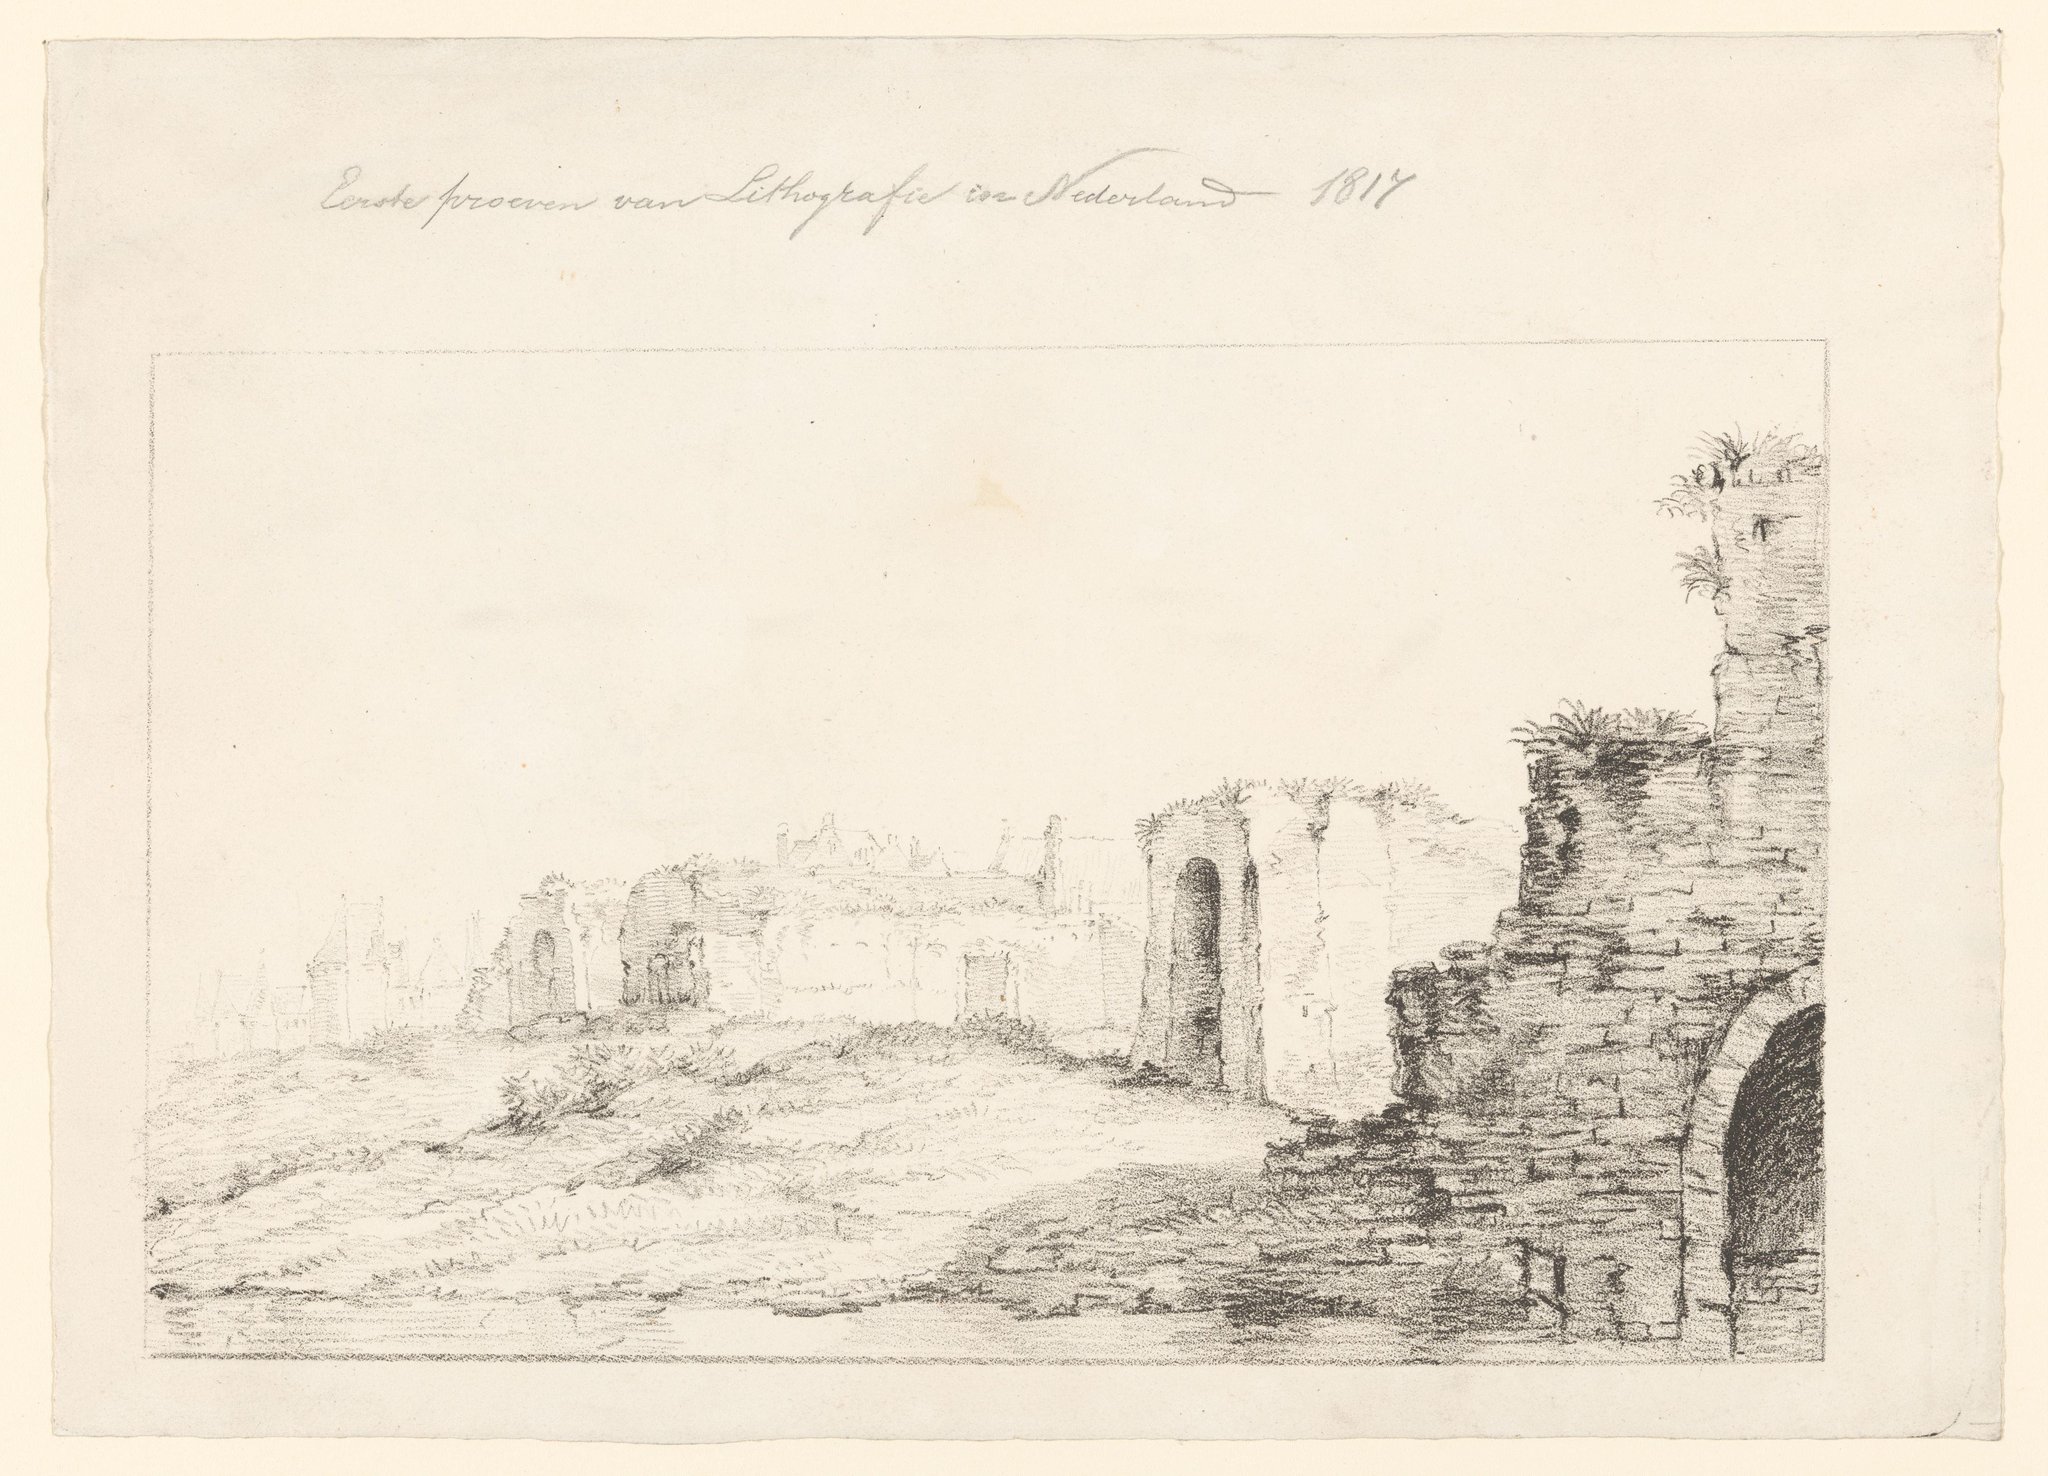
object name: print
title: Ruïnes bij een dorp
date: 1809-1899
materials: paper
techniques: lithograph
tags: landscape with ruins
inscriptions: collector's mark: Lugt 2233, inscription: ‘Eerste proeven van lithografie in Nederland 1817’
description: De vroegst bekende proeven van lithografieën die werden ingediend bij de Koning ten behoeven van octrooi stammen uit 1809 en werden ingediend door Ludwig Plattner (1767-1842). Zie hiervoor: Marres-Schretlen, 1998.